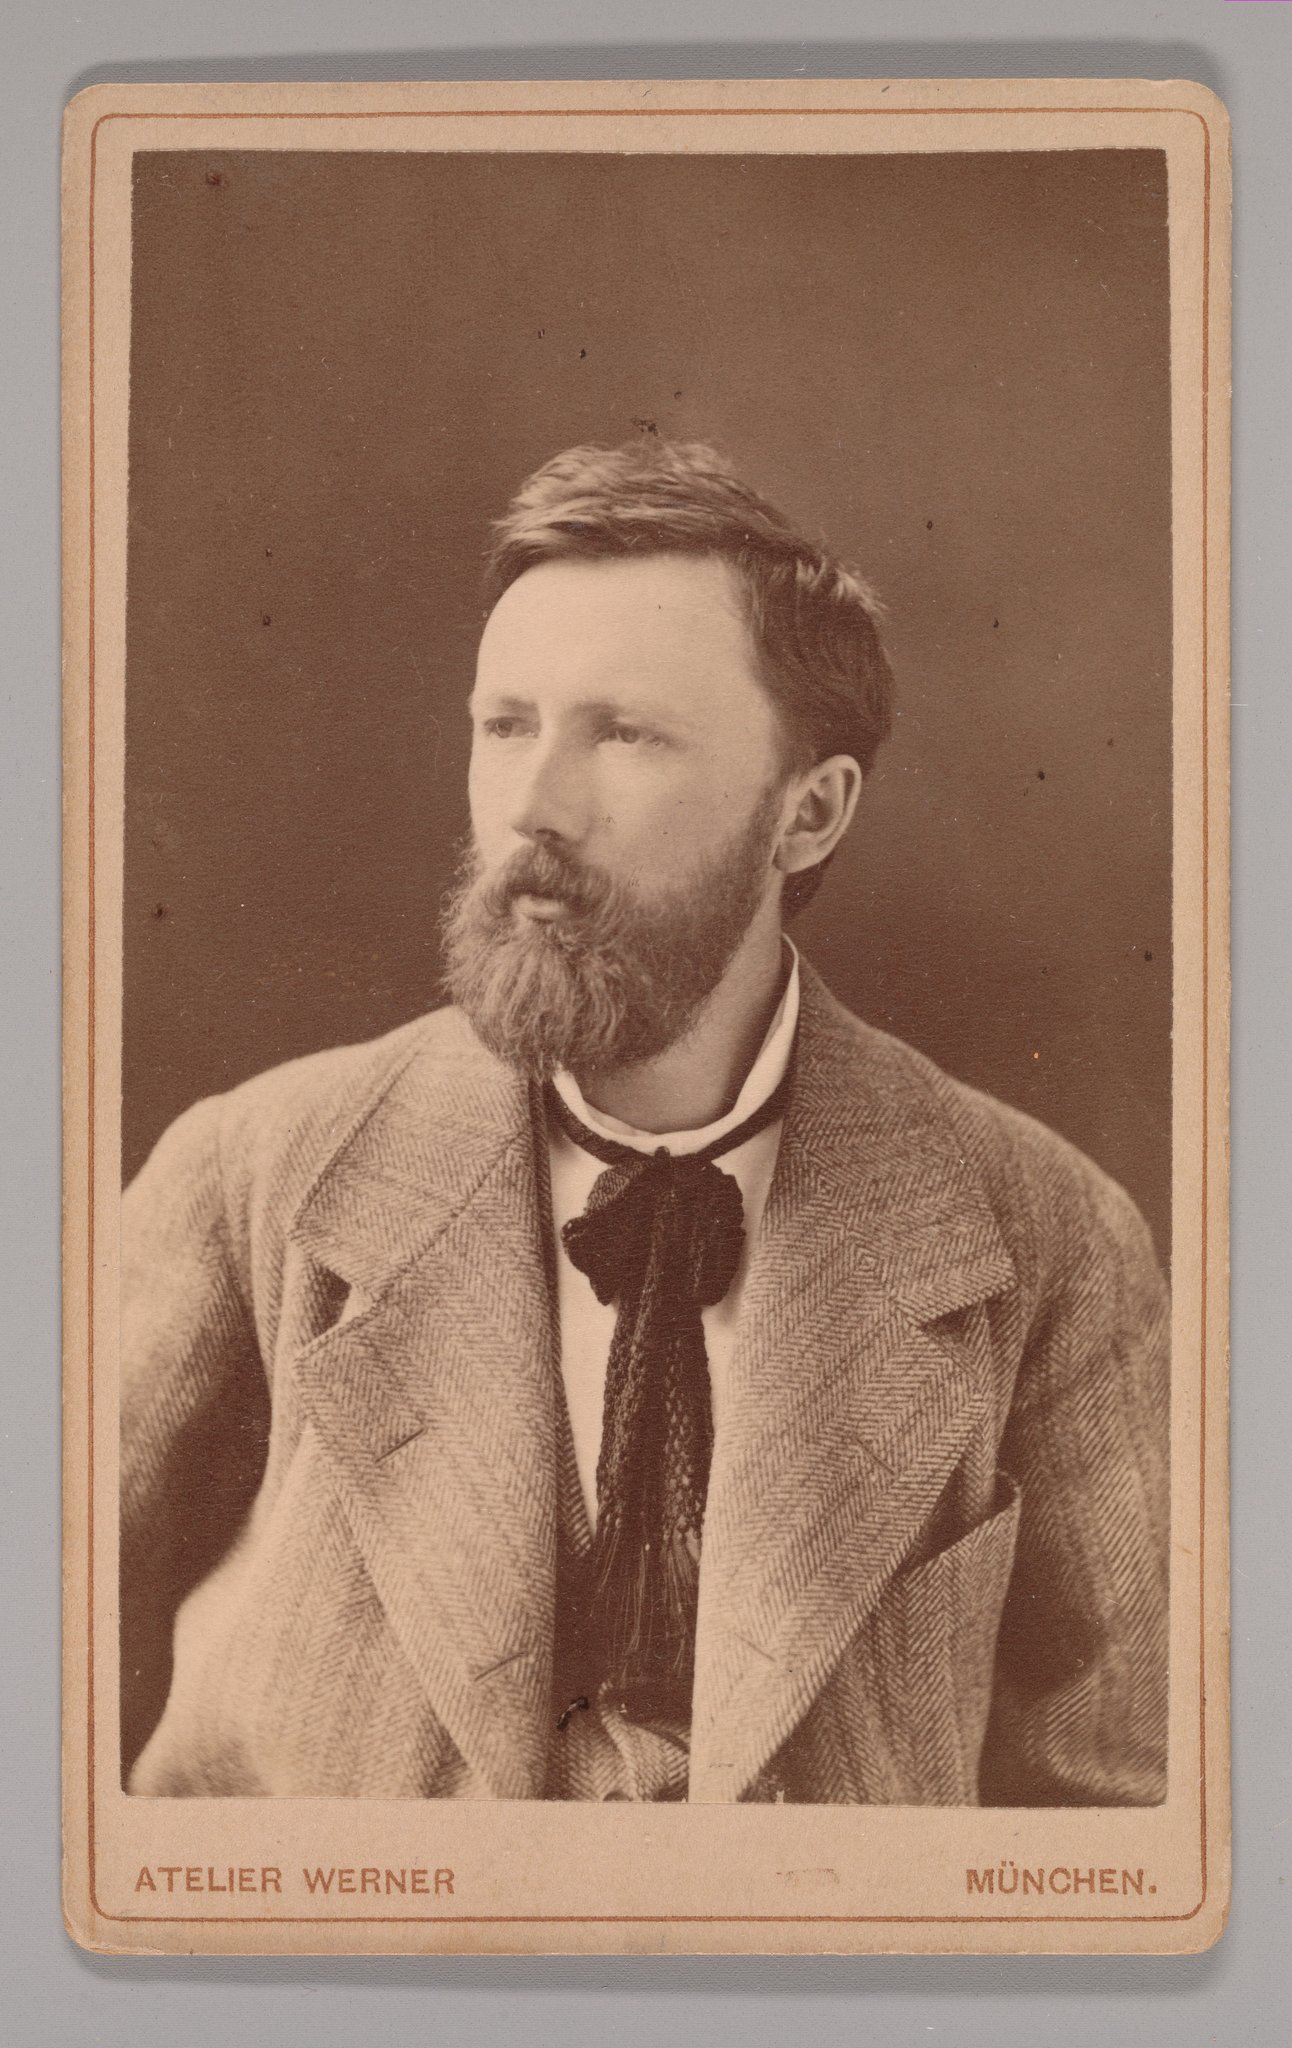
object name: carte de visite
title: [Ludwig von Löfftz]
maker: franz werner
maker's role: artist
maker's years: 1859-1870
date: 1860-1869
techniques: albumen silver print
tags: men,portraits